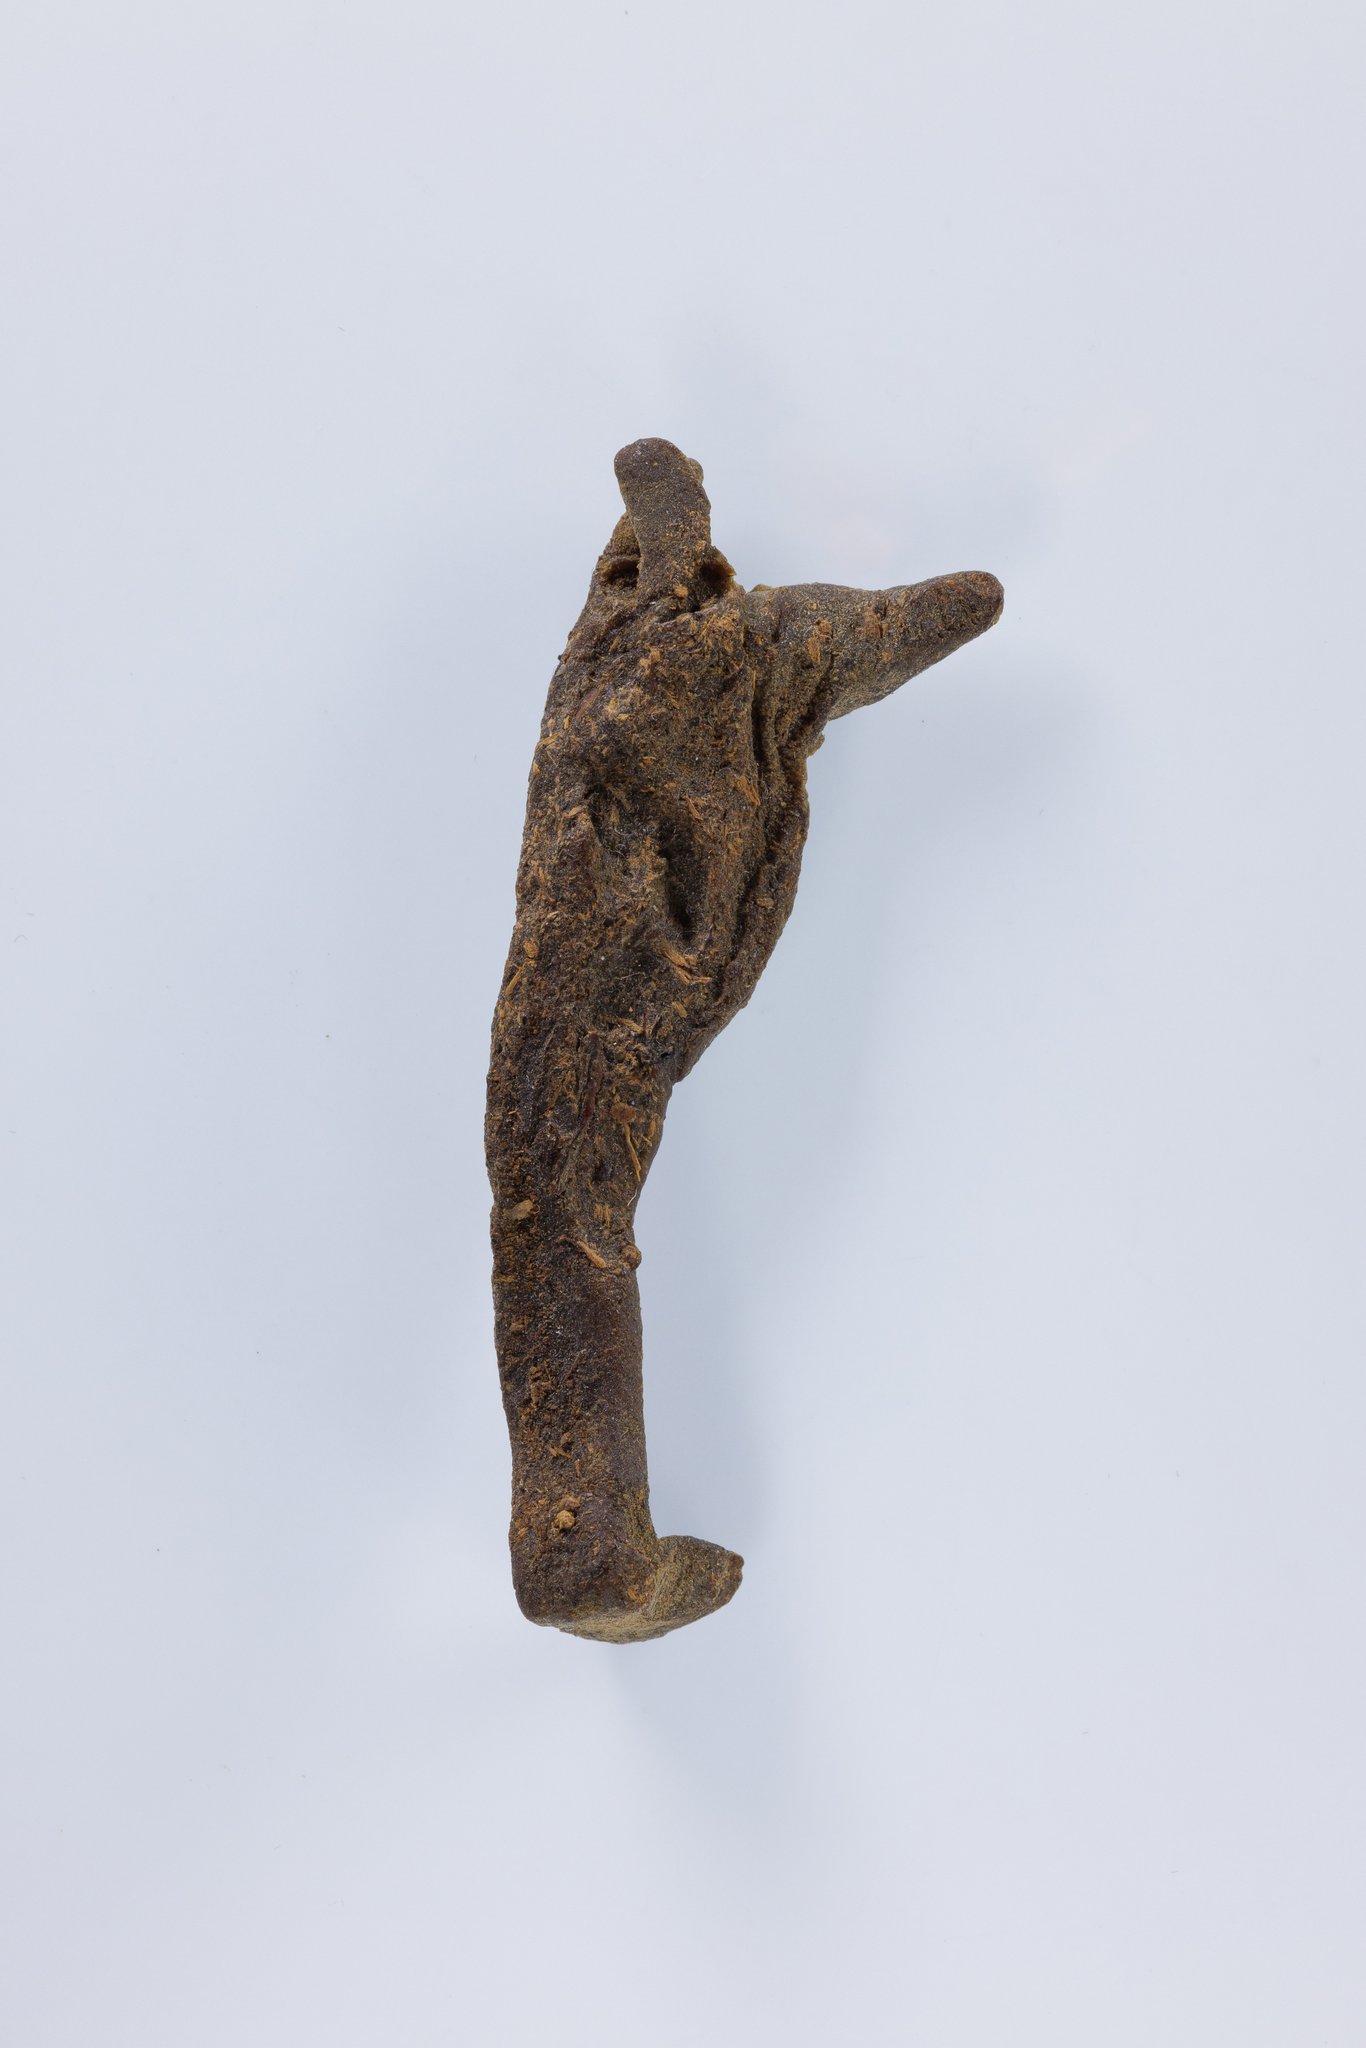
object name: four son of horus, duamutef, jackal headed, tiye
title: Viscera figure with jackal head (Duamutef)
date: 1000-945 BCE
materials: wax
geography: egypt